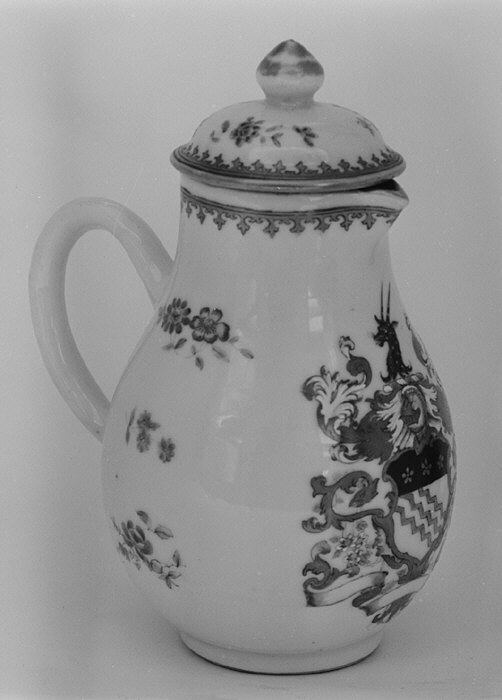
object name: jug with cover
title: Jug with cover (part of a service)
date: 1750-1760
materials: hard paste porcelain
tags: flowers,coat of arms